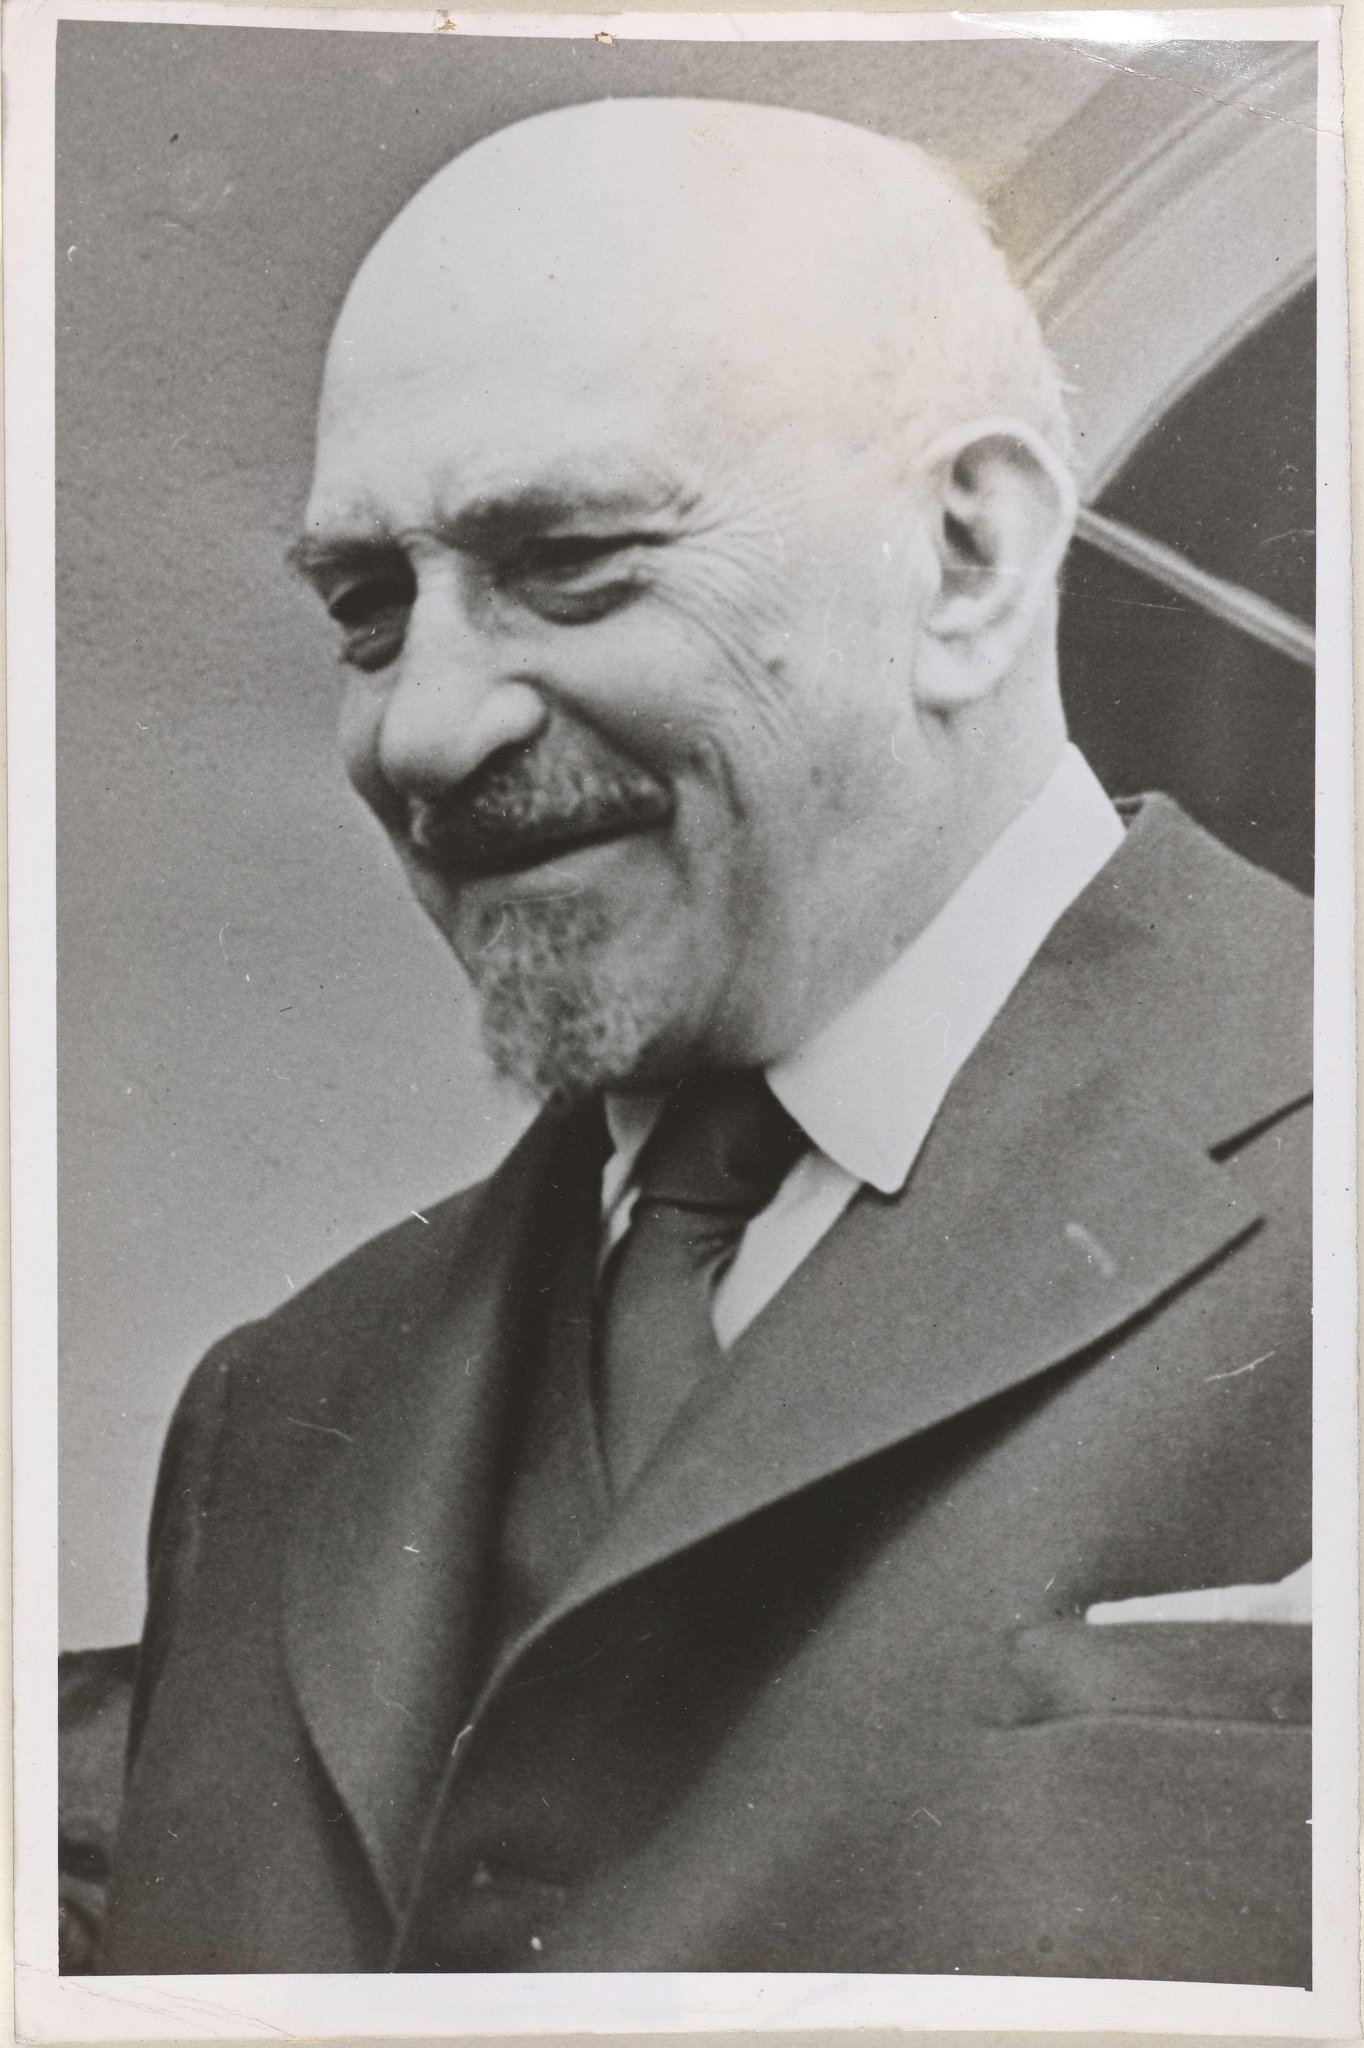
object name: photograph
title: Chaim Weizmann, eerste president Israel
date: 1949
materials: photographic support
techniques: gelatin silver print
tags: president, chaim weizmann, israël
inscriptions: inscription: ‘INP/DNNA Febr. 21, 1949. Dr. Chaim Weizmann, 74 year old...’